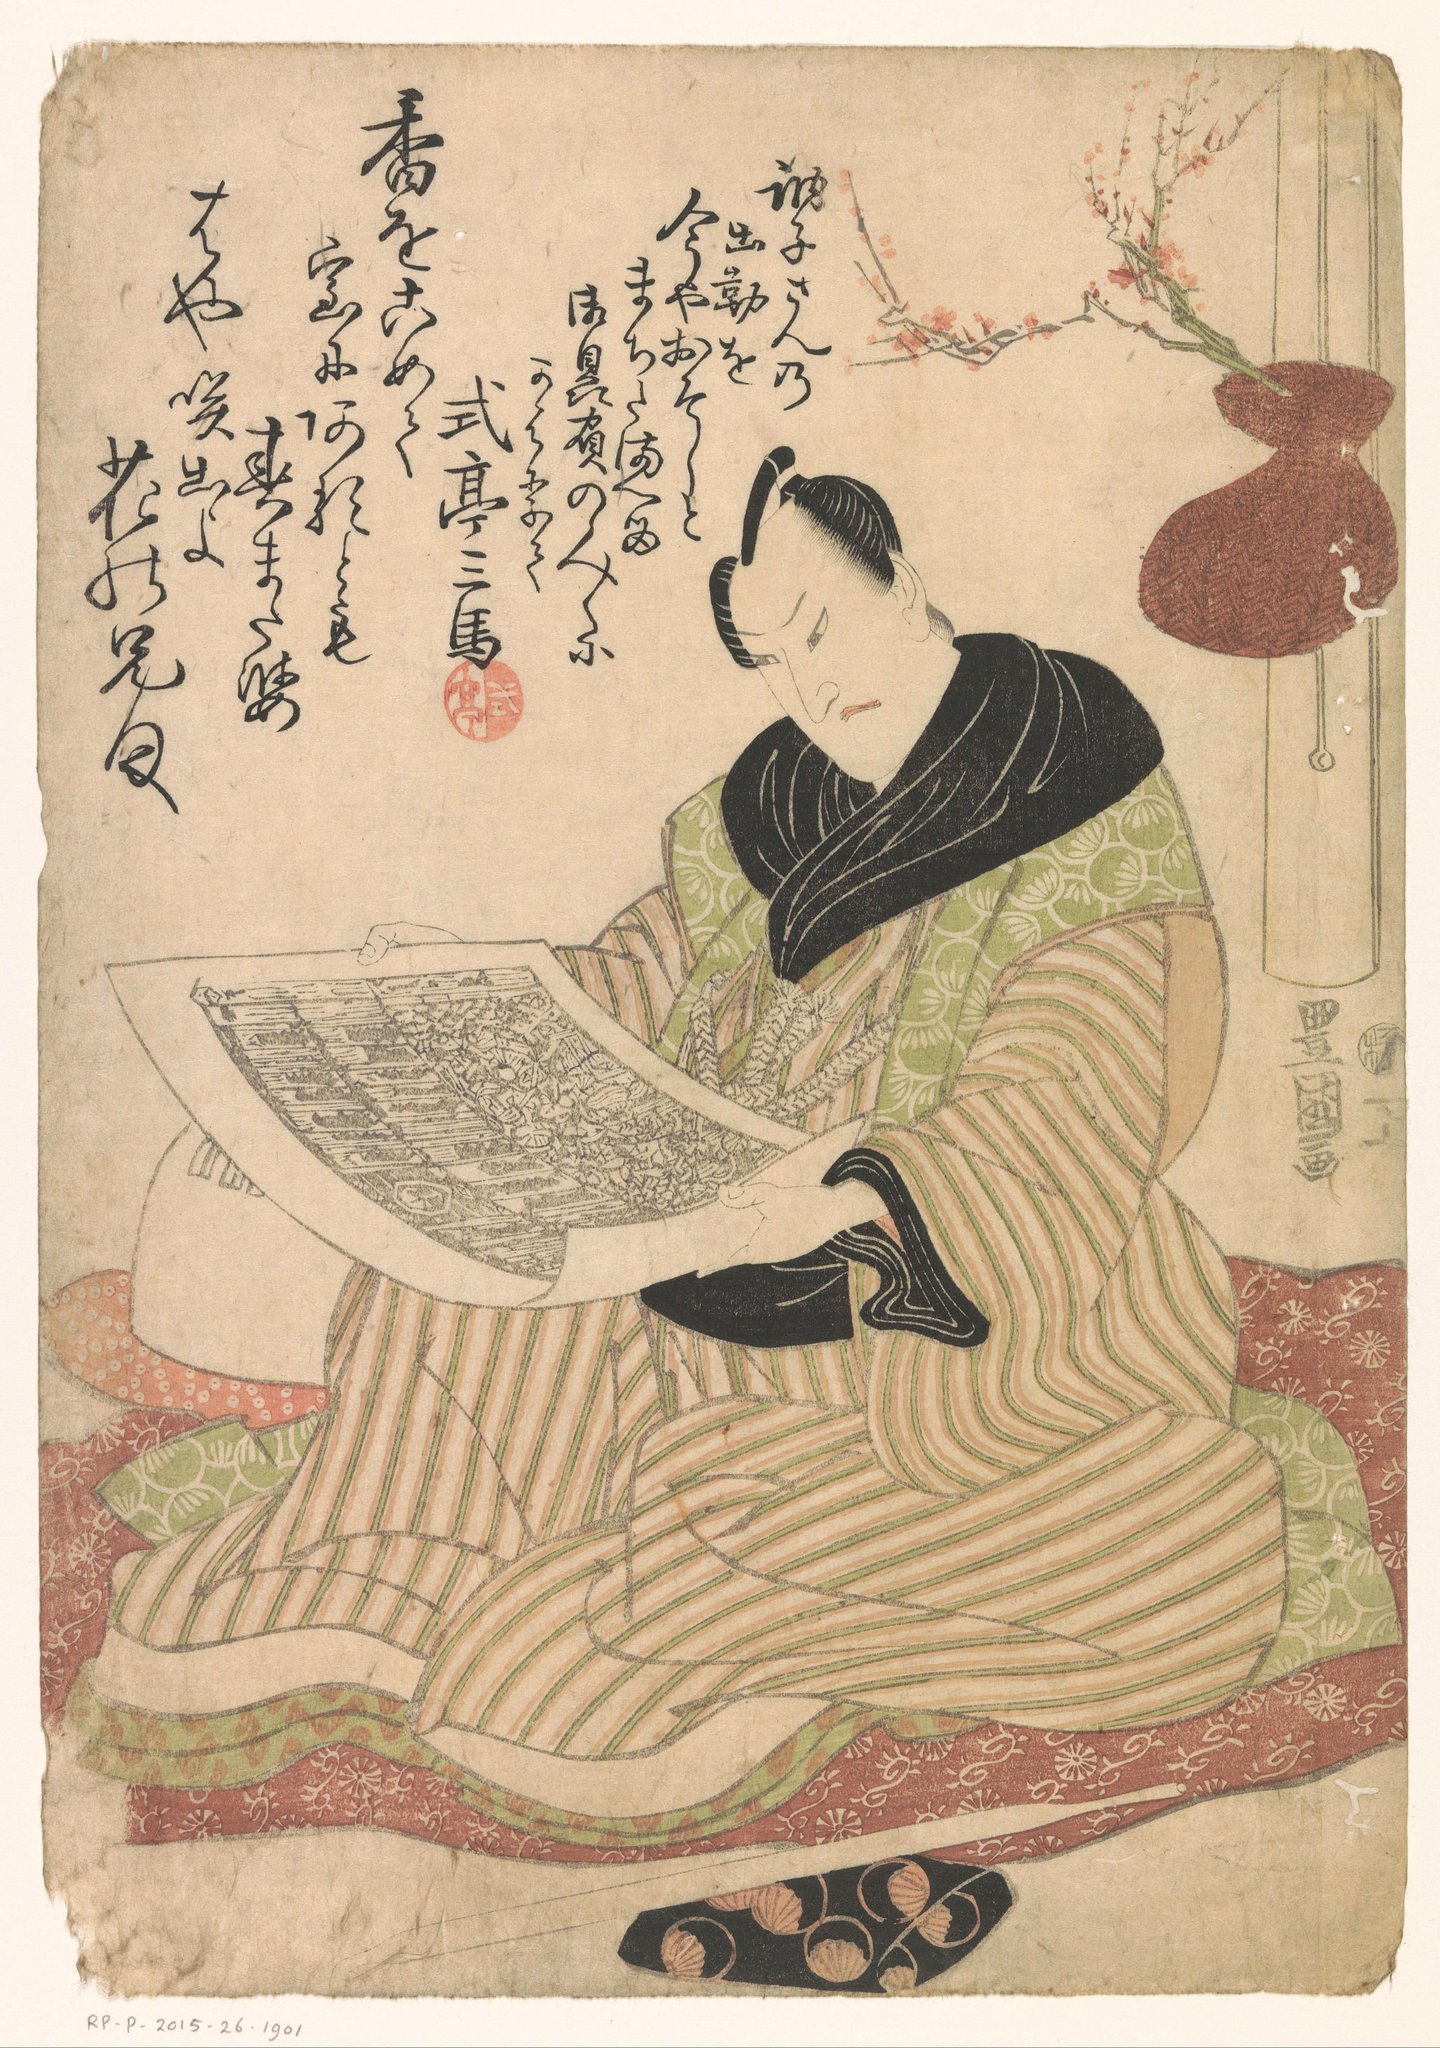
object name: print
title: Man met een prent in zijn handen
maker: utagawa toyokuni (i)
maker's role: print maker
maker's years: 1769-1825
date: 1779-1825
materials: paper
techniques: woodcut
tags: print, e.g.: engraving, etching, lithograph, art collector (+ graphic arts)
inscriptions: collector's mark: Lugt 4780